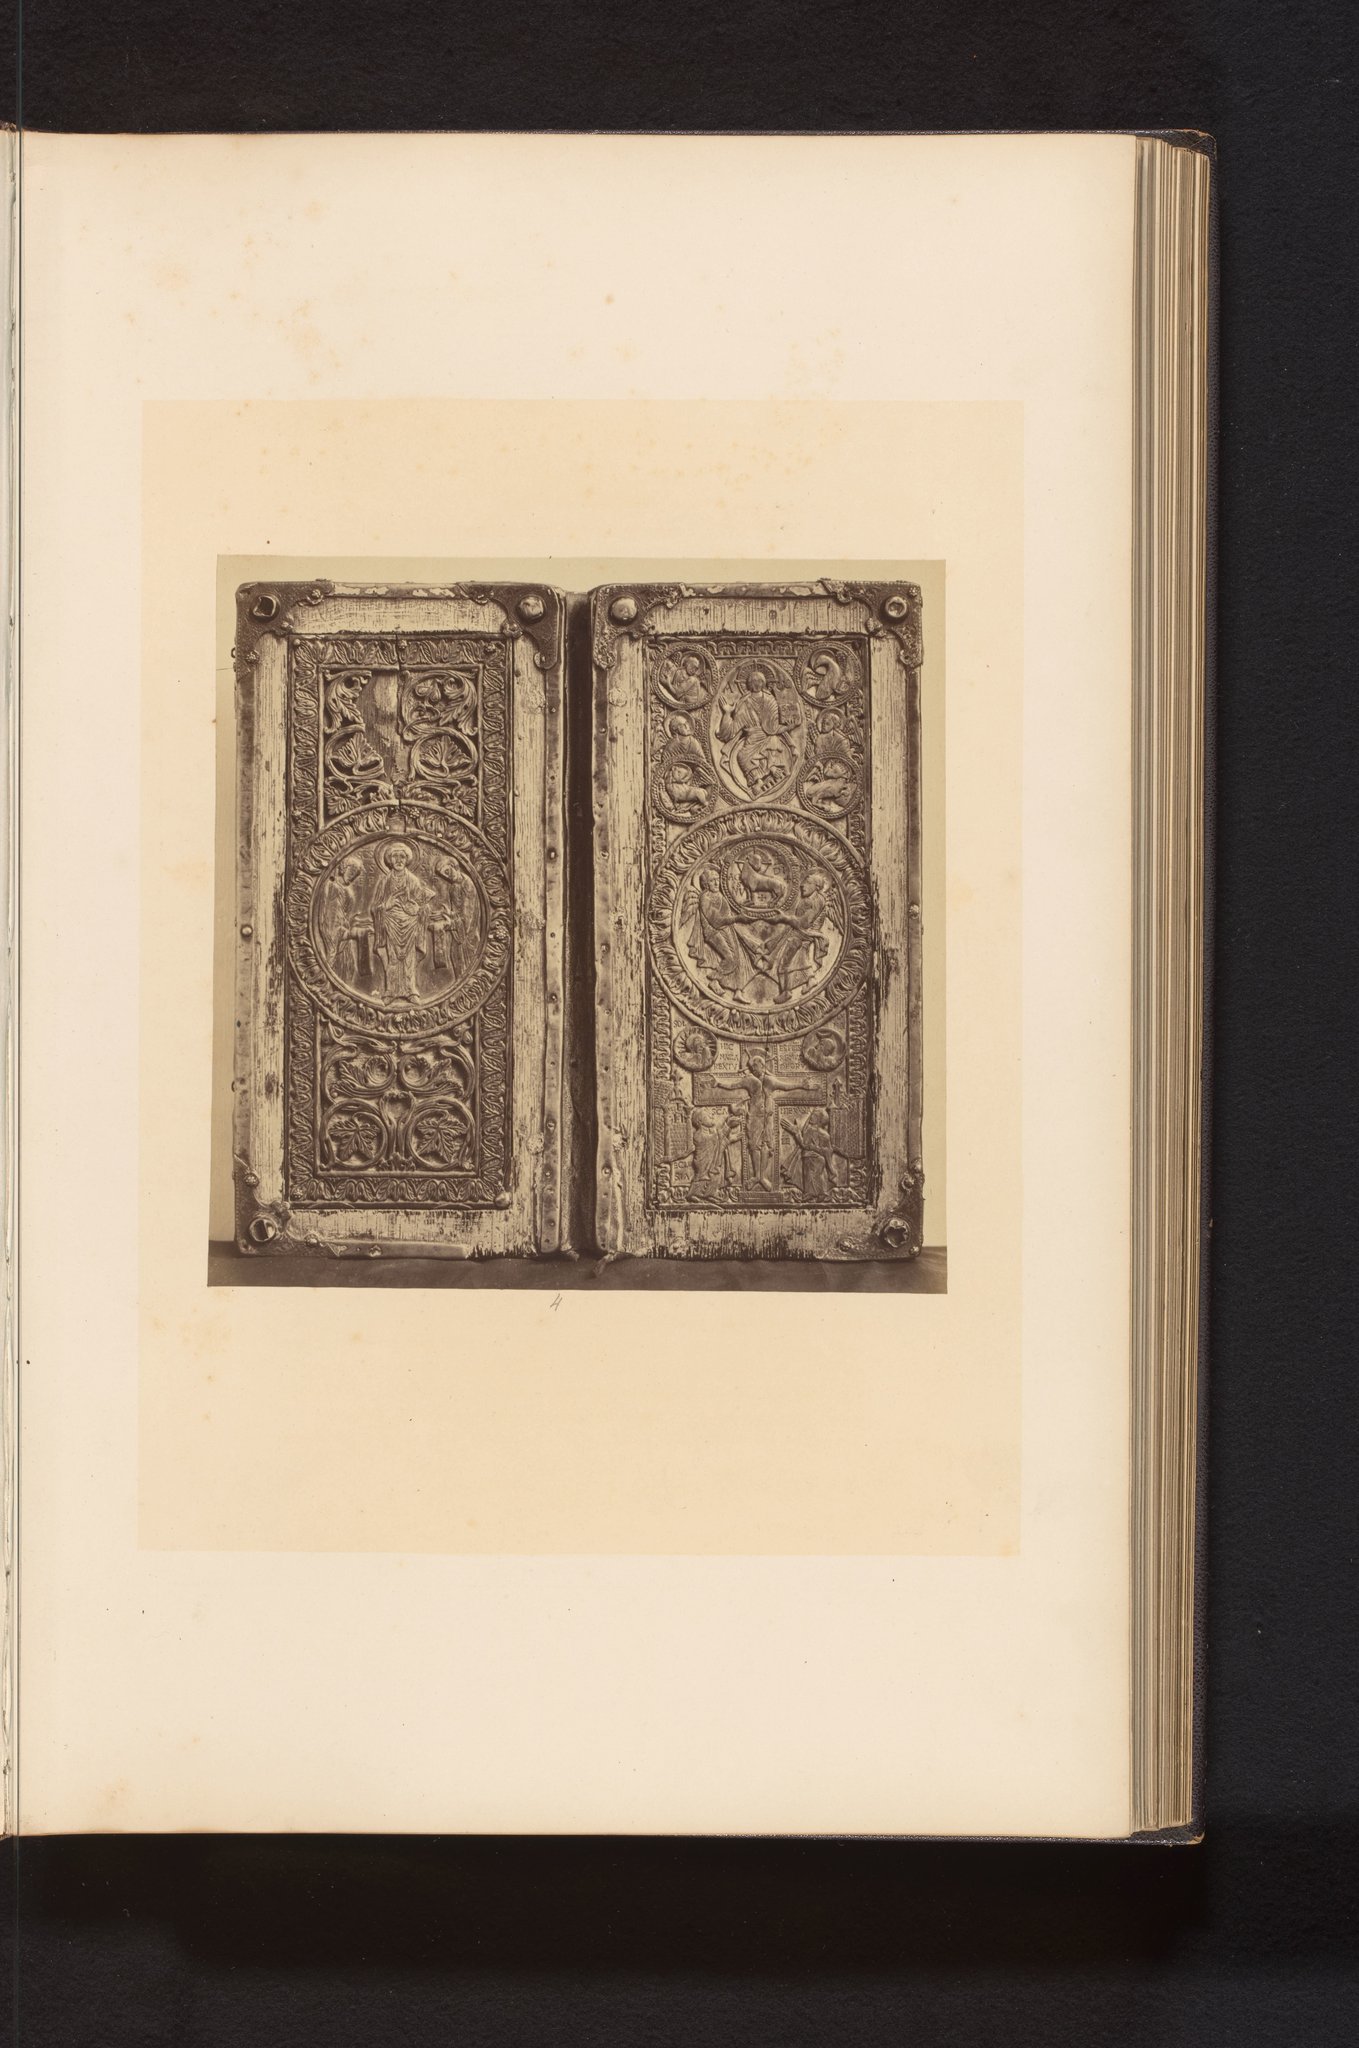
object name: photograph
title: Tweeluik van ivoor met voorstellingen uit het Nieuwe Testament, uit de Onze-Lieve-Vrouwekathedraal in Doornik, opgesteld op een tentoonstelling over religieuze objecten uit de middeleeuwen en renaissance in 1864 in Mechelen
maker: joseph maes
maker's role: fotograaf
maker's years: 1838-1908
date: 1864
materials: photographic support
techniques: albumen print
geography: mechelen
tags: piece of sculpture, reproduction of a piece of sculpture (+ bone, ivory ~ arts), new testament, mechelen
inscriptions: number: ‘4’